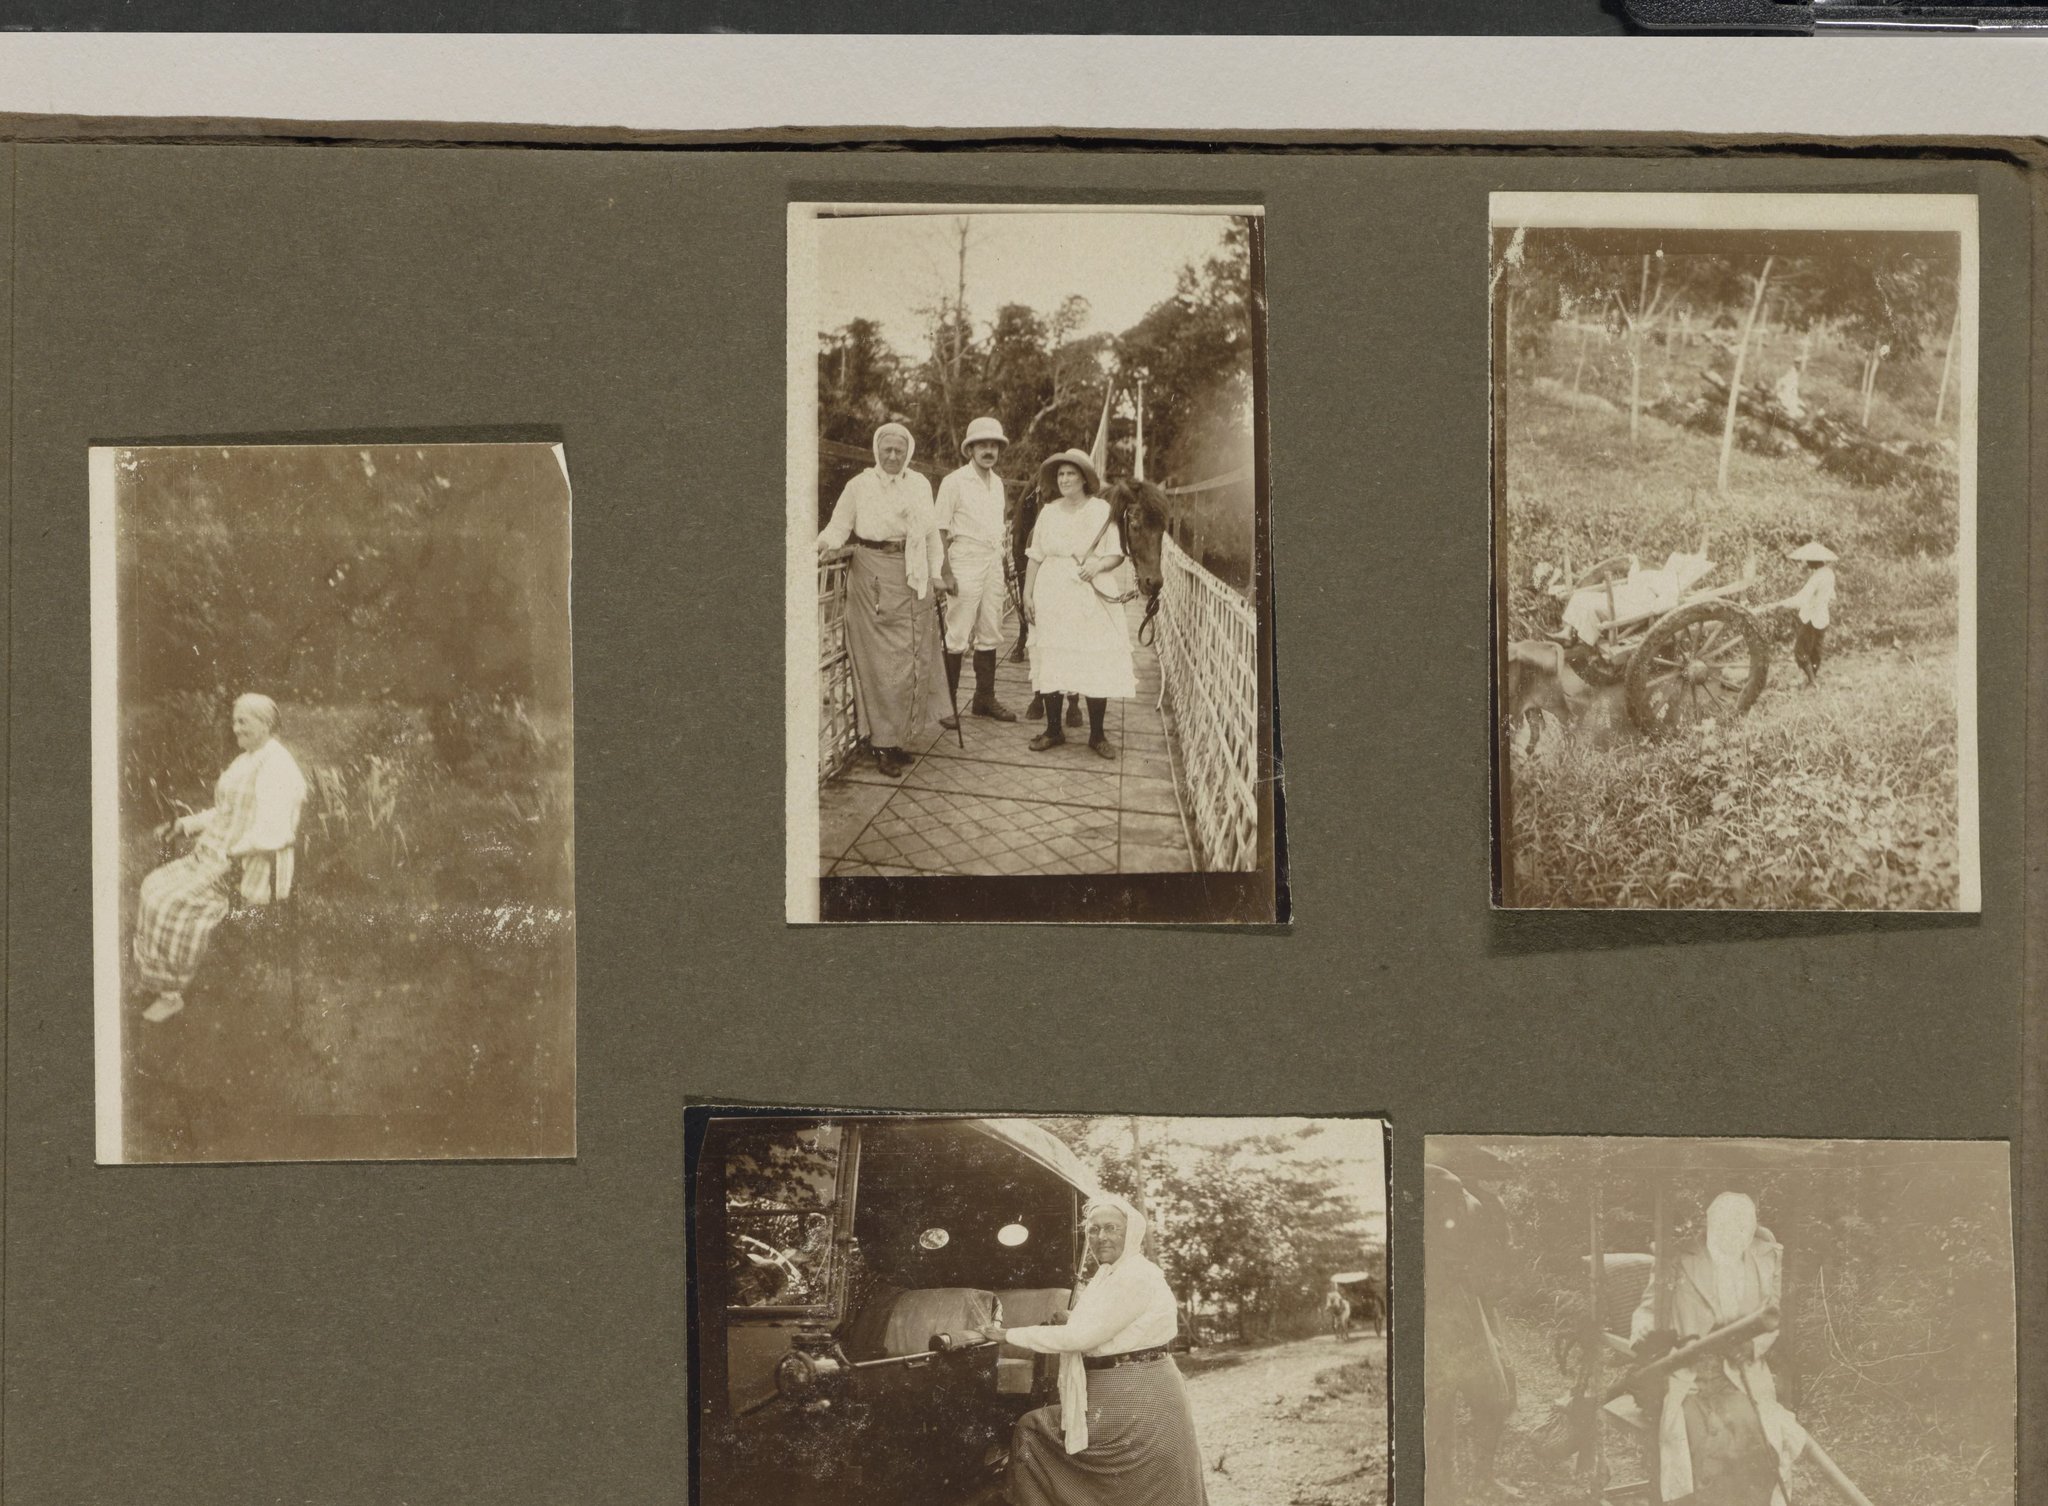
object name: album leaf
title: Leprozenkolonie Danaradja: personen en transport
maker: Anonymous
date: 1922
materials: cardboard, photographic support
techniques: collodion silver print, daylight paper print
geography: kelet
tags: two-wheeled, animal-drawn vehicle, (carrying a person in a) sedan-chair, horse, automobile, leprosy, historical persons not known by name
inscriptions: inscription: ‘Hier is haar hoofd meer gedraait.’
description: Albumblad met vijf foto's: geheel links een vrouw zittend op een stoel in een tuin, midden boven twee vrouwen en een man in rijkleding bij een paard. Rechtsboven vervoerd een Indische man een liggende persoon met een tjikar (ossenkar). Midden onder stapt een oude vrouw in een auto. Rechtsonder een vrouw zittend in een draagstoel. Haar hoofd is uit de foto gemonteerd. Onderdeel van Fotoalbum leprozenkolonie Danaradja en familieopnames.